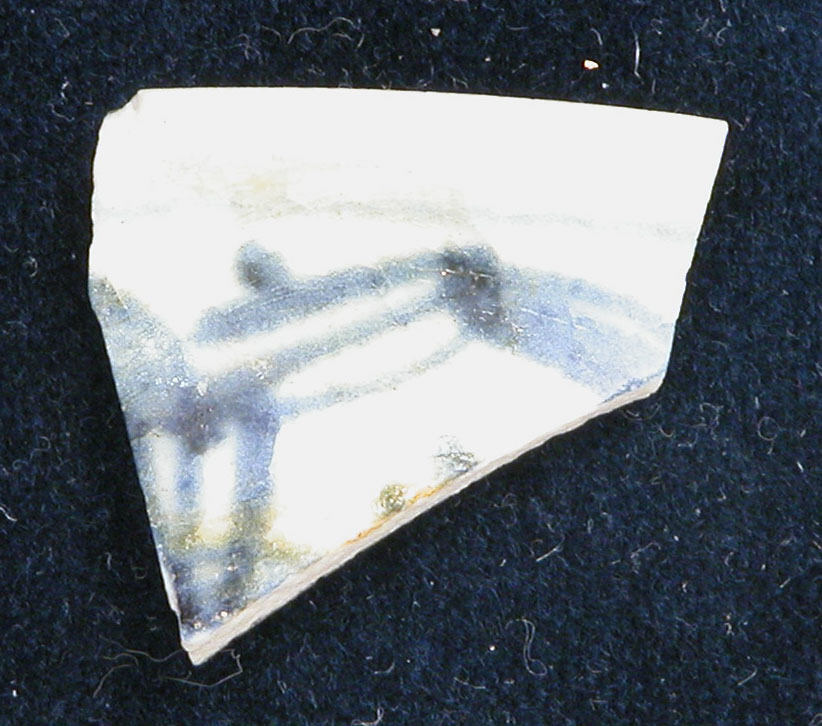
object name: fragment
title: Ceramic Fragment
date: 1201-1400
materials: porcelain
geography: saudi arabia